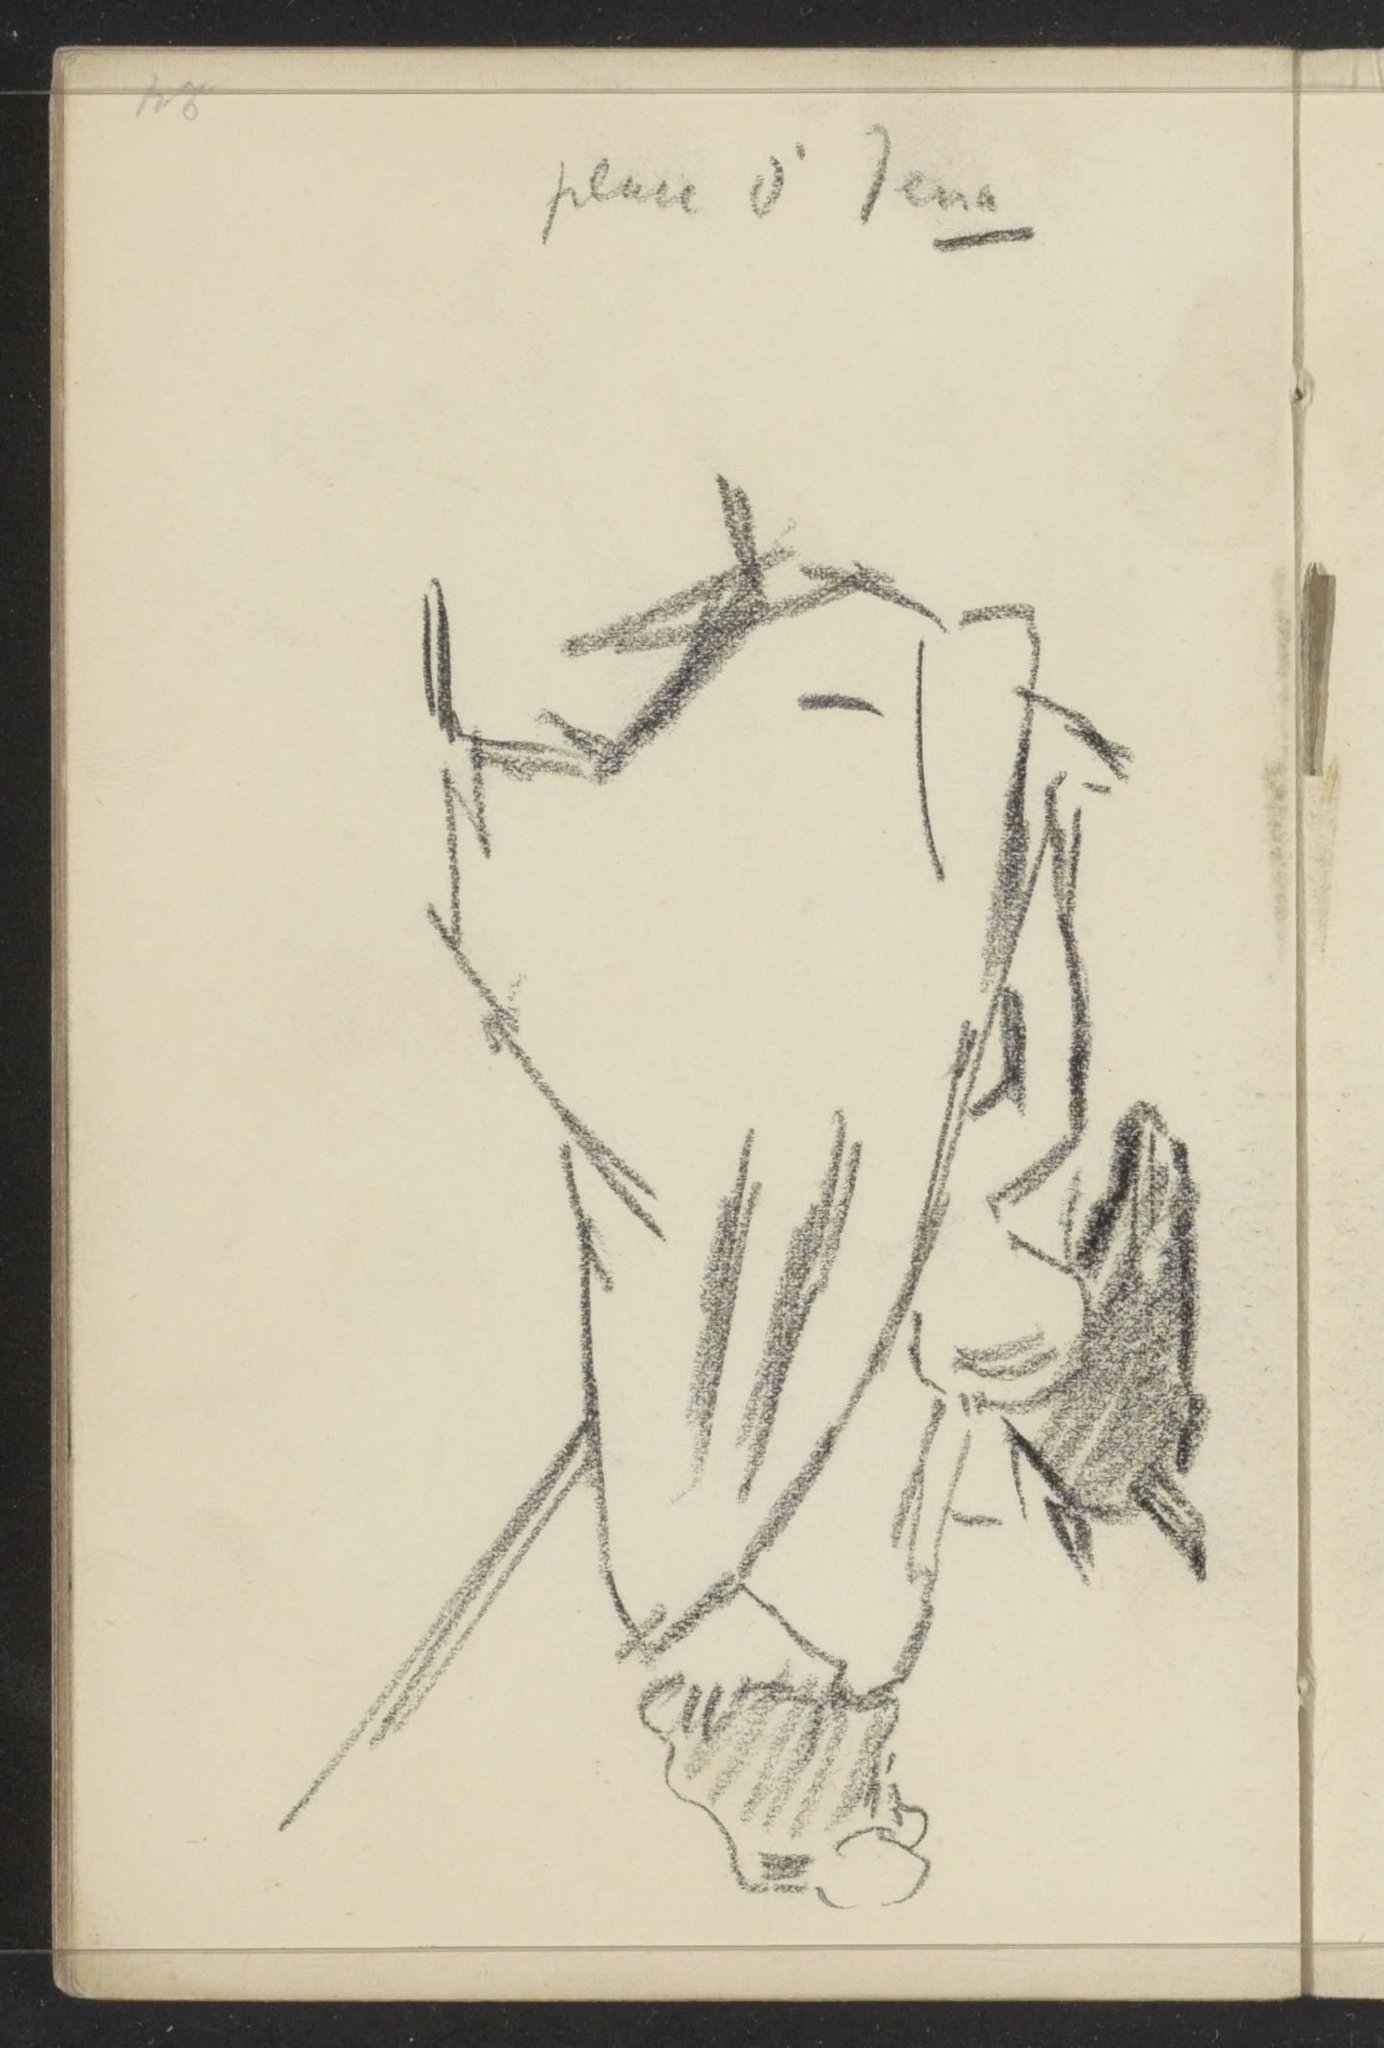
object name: sketchbook leaf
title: Ruiter, op de rug gezien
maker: isaac israels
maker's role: draughtsman, painter, print maker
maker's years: 1865-1934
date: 1887-1934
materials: chalk, paper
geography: paris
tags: riding a horse, ass, or mule; rider, horseman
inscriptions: annotation: ‘Place d'Iena’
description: Mogelijk gezien op het Place d'Iena te Parijs. Blad 19 verso uit schetsboek LIX met 21 bladen.